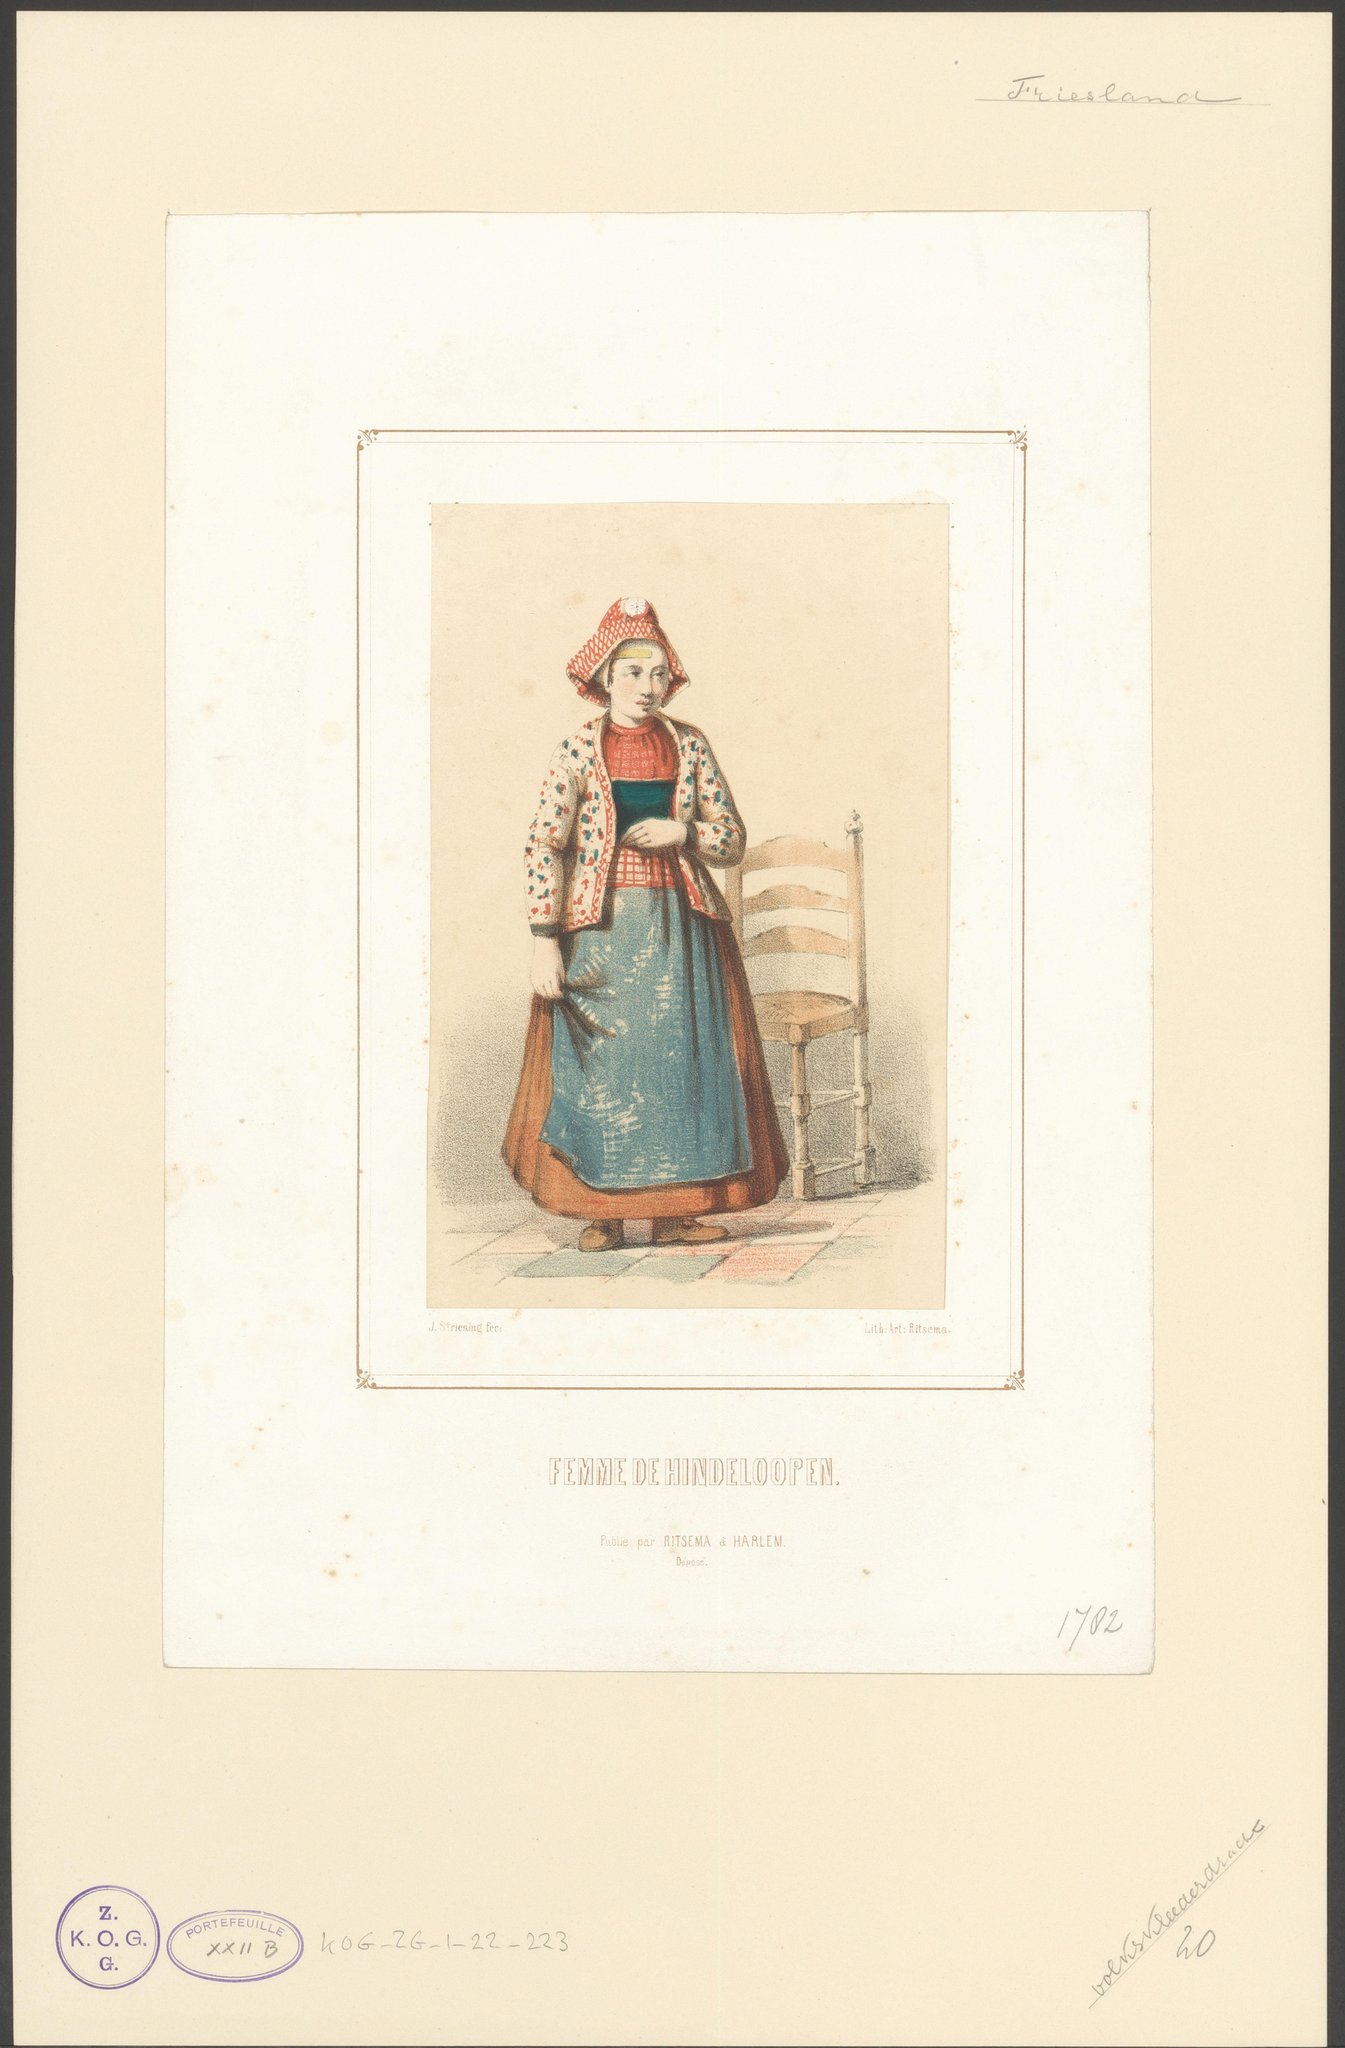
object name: print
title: Vrouw van Hindeloopen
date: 1858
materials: watercolor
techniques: hand coloring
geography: netherlands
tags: clothes, costume (+ women's clothes), folk costume, regional costume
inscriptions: collector's mark, collector's mark: Lugt 1641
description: Jonge vrouw van Hindeloopen, staande bij een stoel. Onderwerpsrubrieken binnen de Atlas Zeden en Gewoonten: De Kleeding, Volkskleederdracht, Friesland.